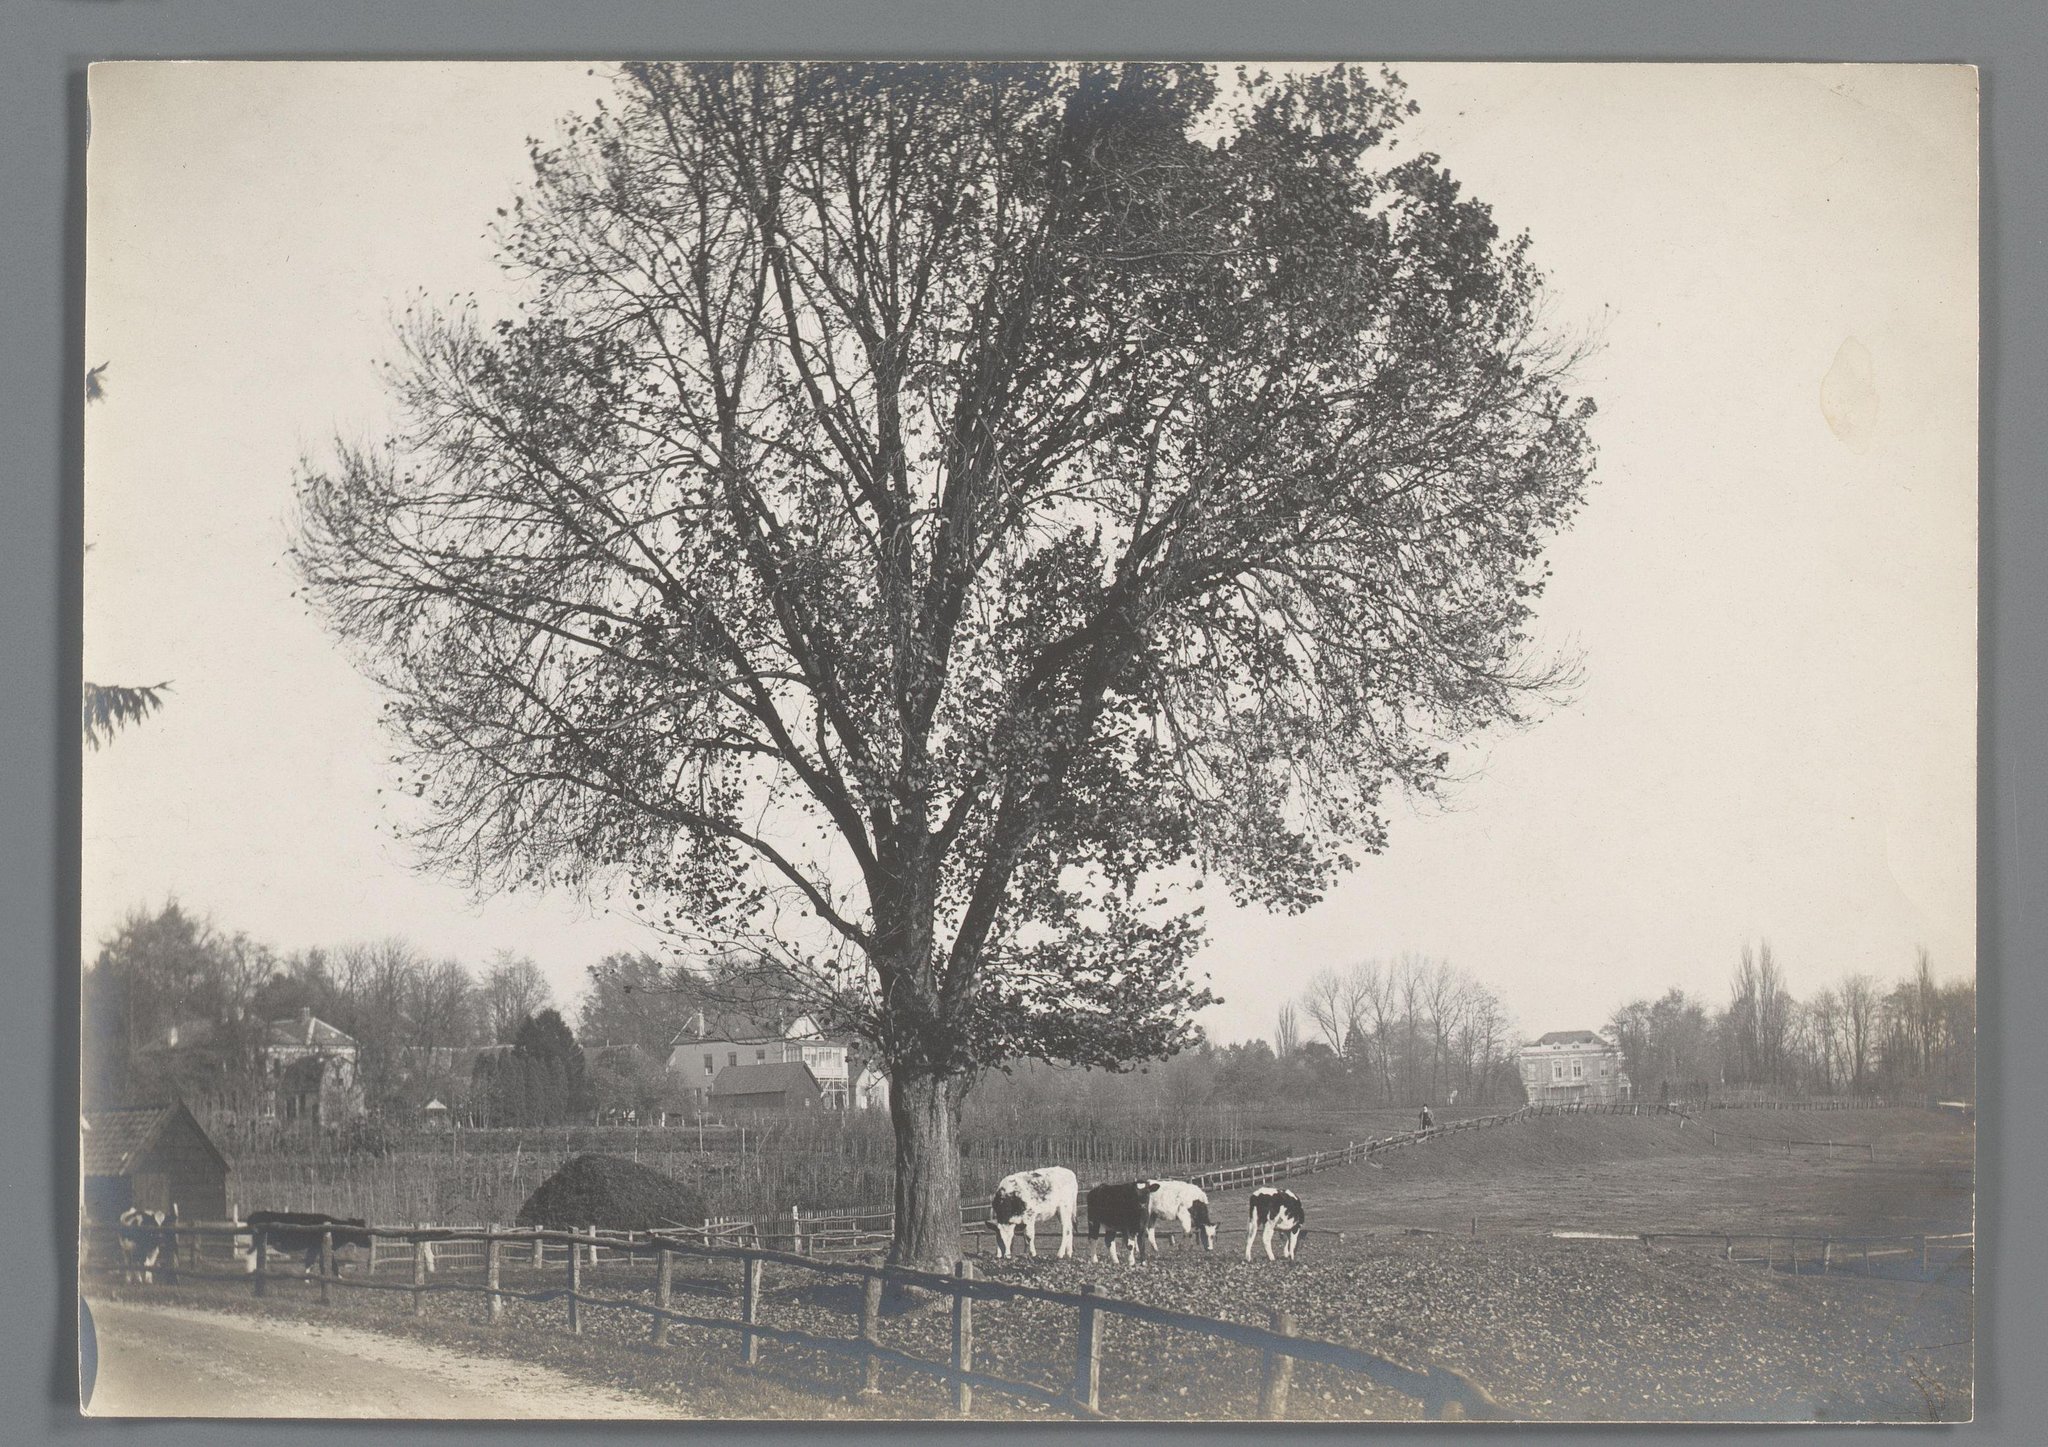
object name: photograph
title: Koeien onder een boom in een weiland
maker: willem de jong (fotograaf)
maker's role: arts, fotograaf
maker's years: 1864-1918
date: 1895-1918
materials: paper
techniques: gelatin silver print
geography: netherlands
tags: trees, cow, meadow, pasture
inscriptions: inscription: ‘foto Willem de Jong’